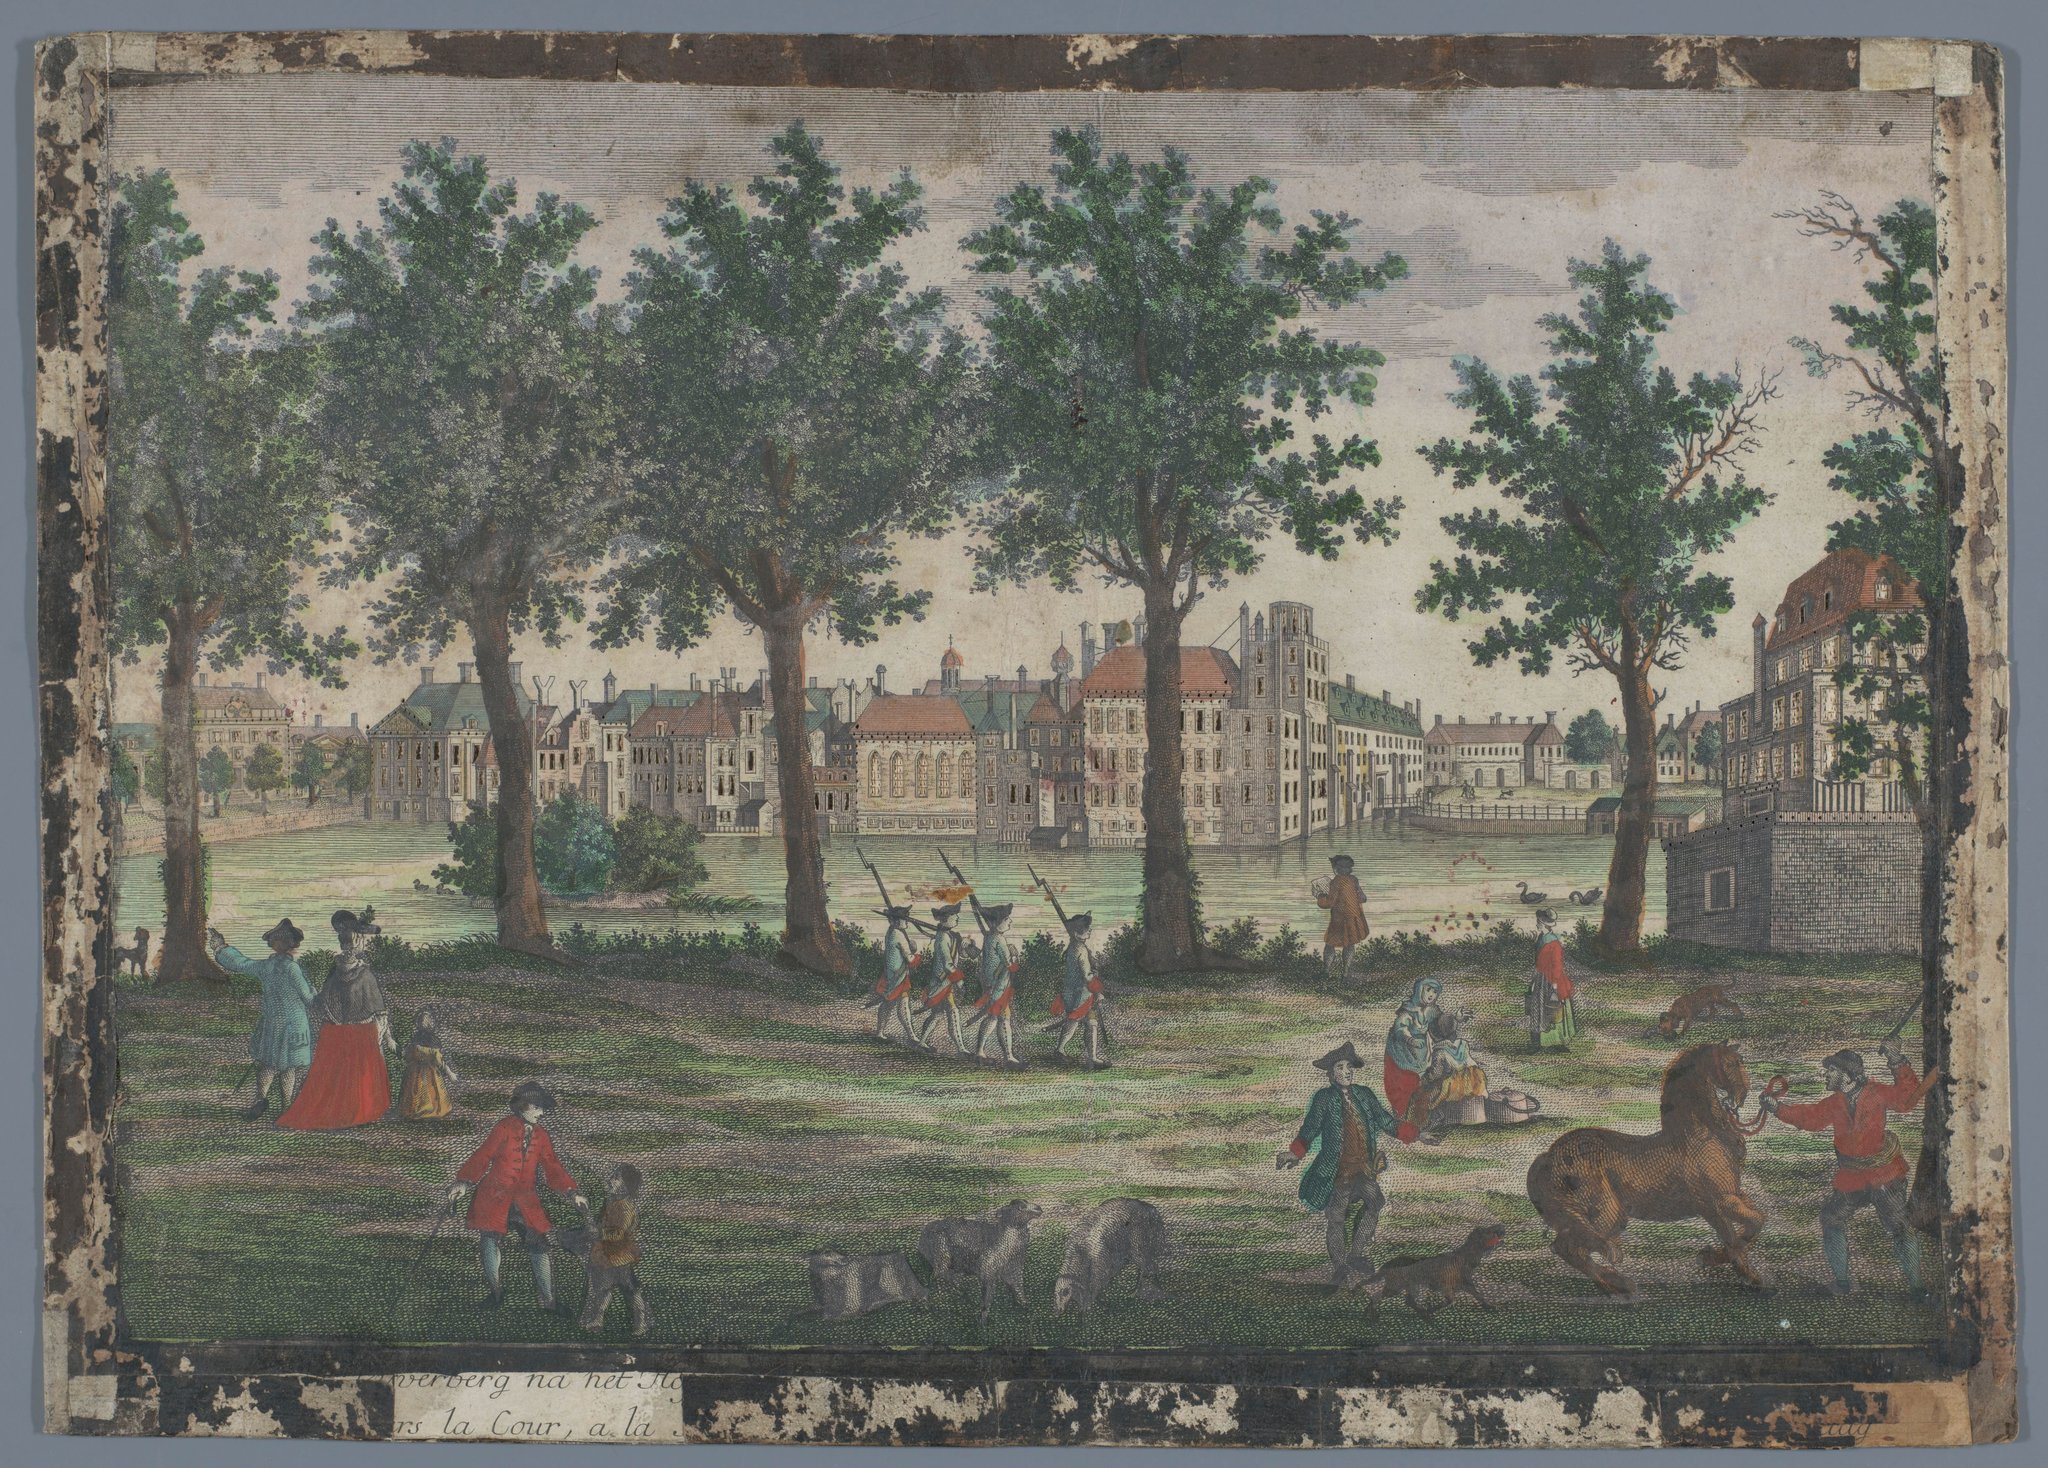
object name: opticaprent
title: Gezicht op de Hofvijver te Den Haag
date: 1742-1801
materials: cardboard, paint, paper, watercolor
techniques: brush, cutting, etching, perforating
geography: germany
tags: parts of church exterior and annexes: chapel, canals, waters (in city) (+ city(-scape) with figures, staffage), street (+ city(-scape) with figures, staffage)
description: Mogelijk rechtsboven genummerd geweest: 263. Mogelijk linksonder genummerd geweest: 65. De serie “Den Haag”, met het nummer 65, bevat vier prenten met de nummers 262-265, waarvan dit mogelijk nummer 263 is.